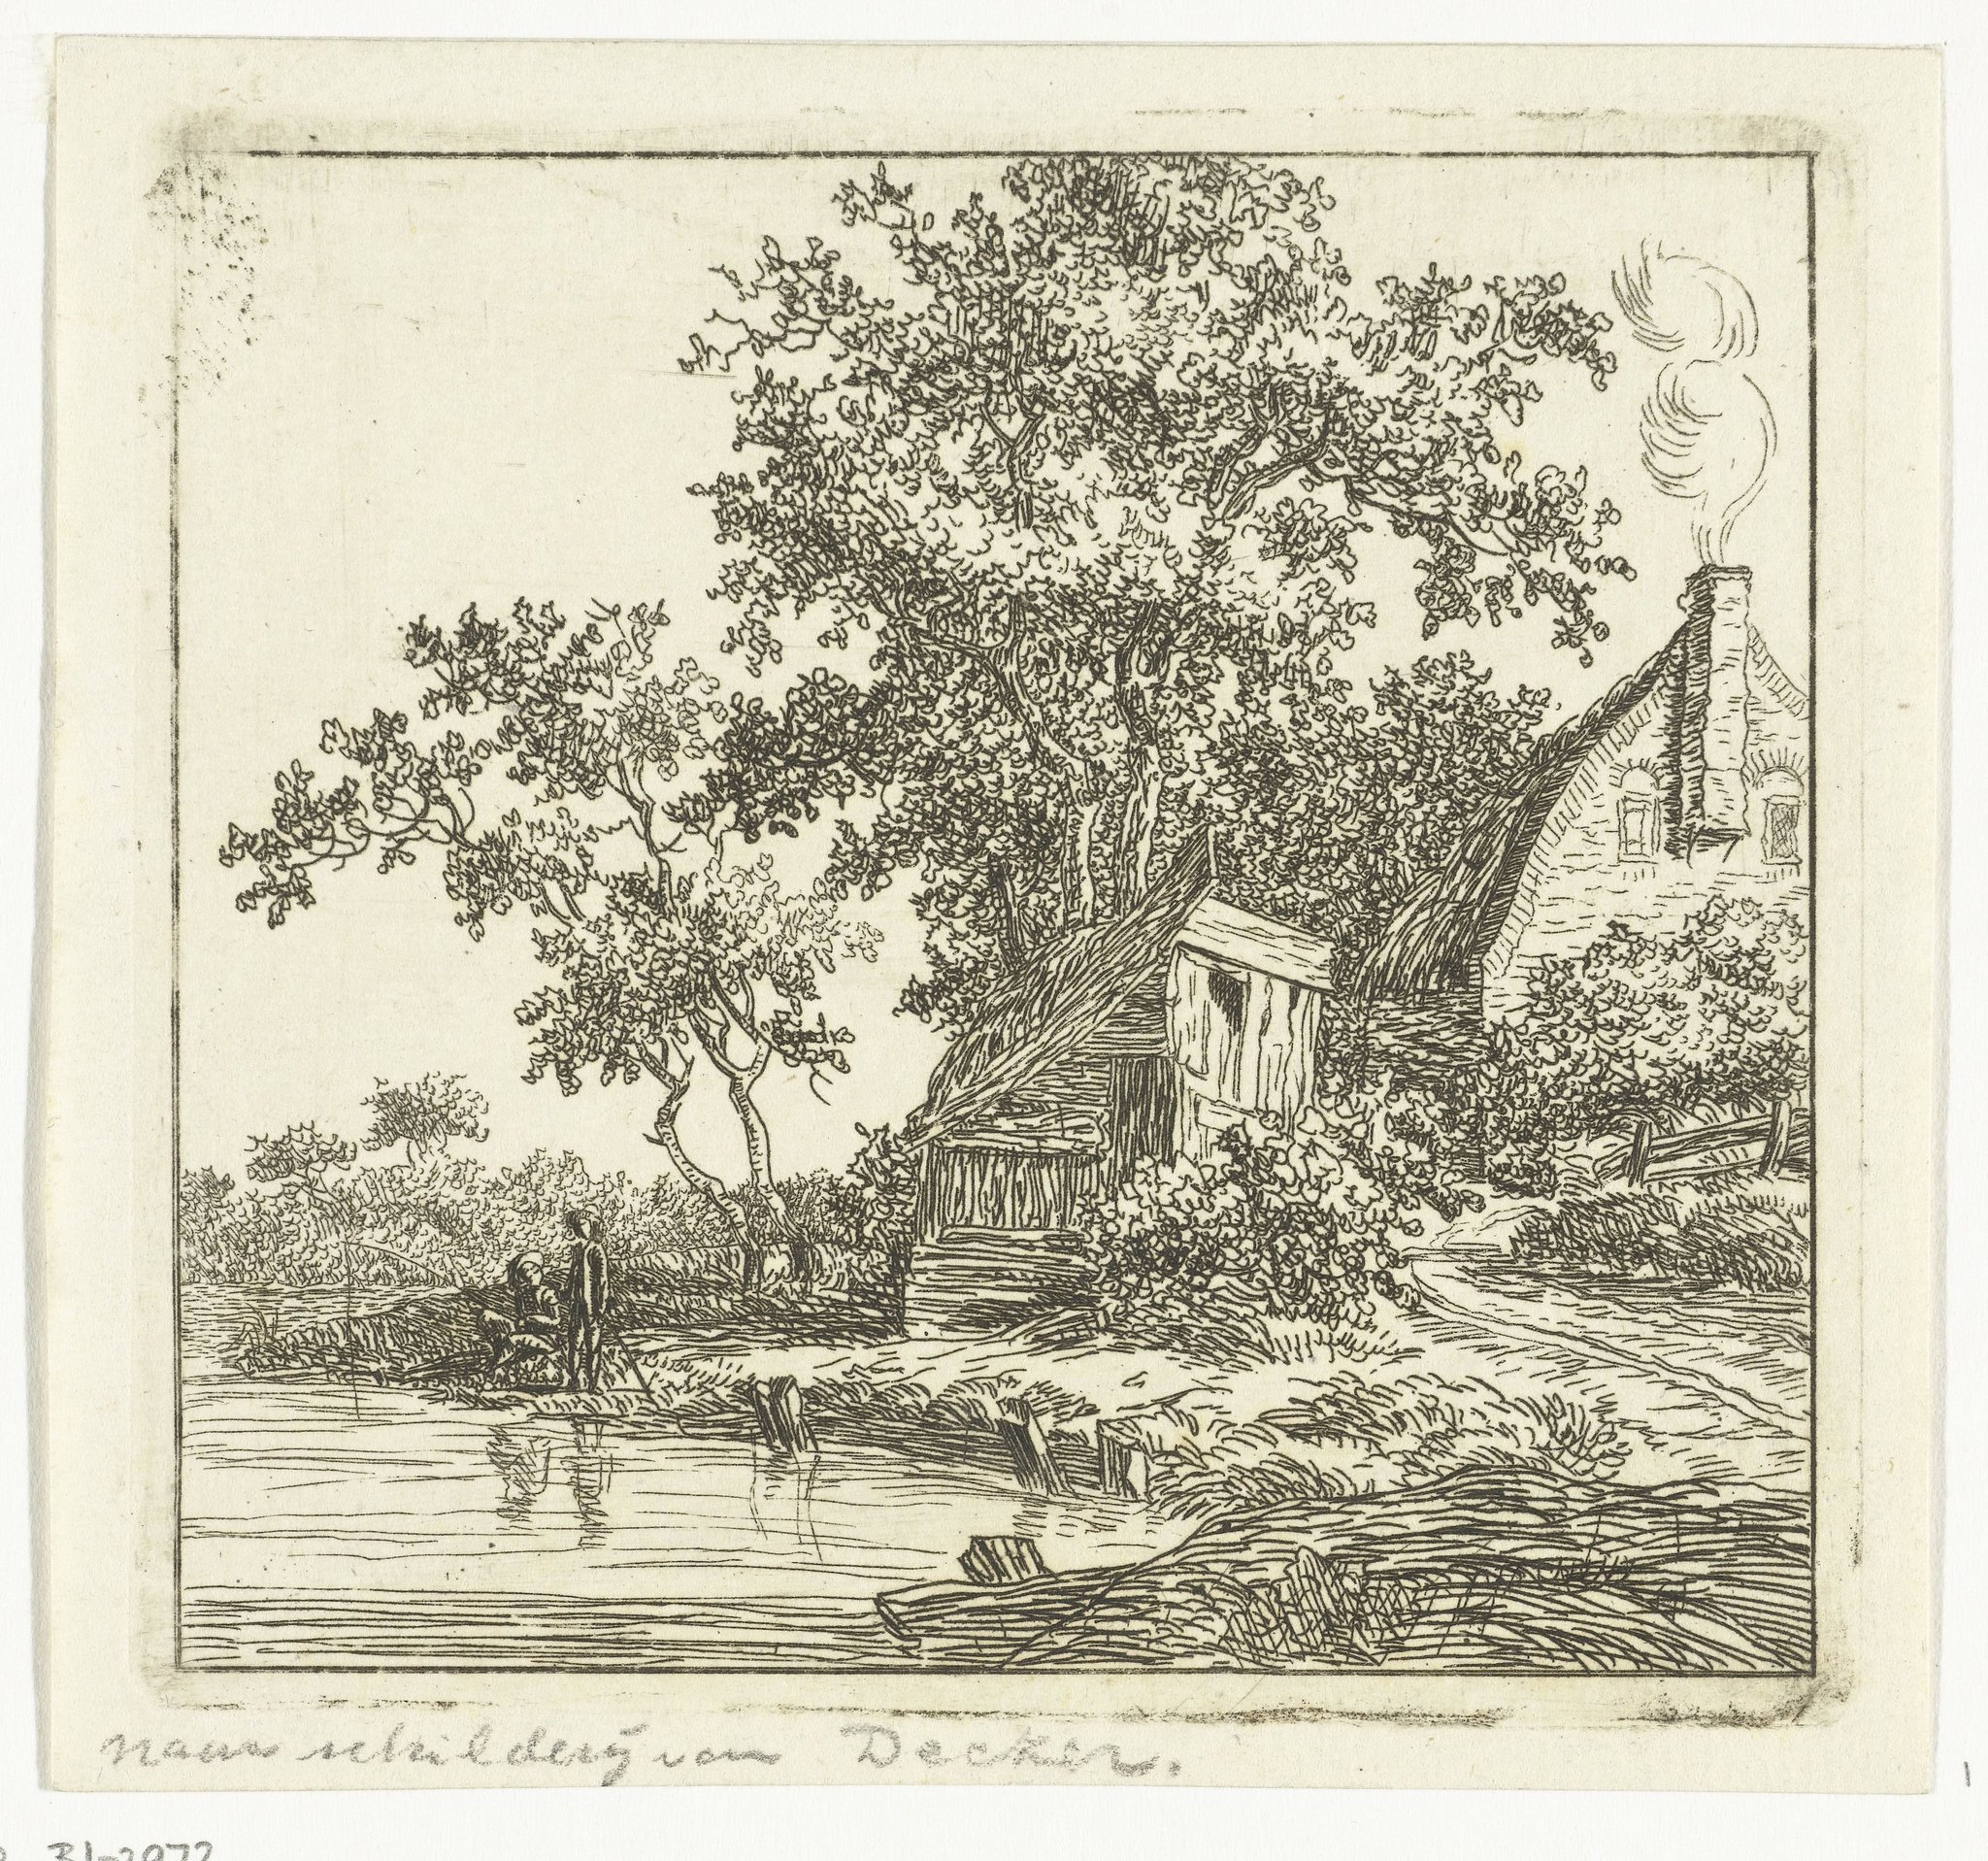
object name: print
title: Hengelaar bij schuurtje aan het water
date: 1778-1838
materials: paper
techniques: etching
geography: netherlands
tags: angling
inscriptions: collector's mark: Lugt 2228